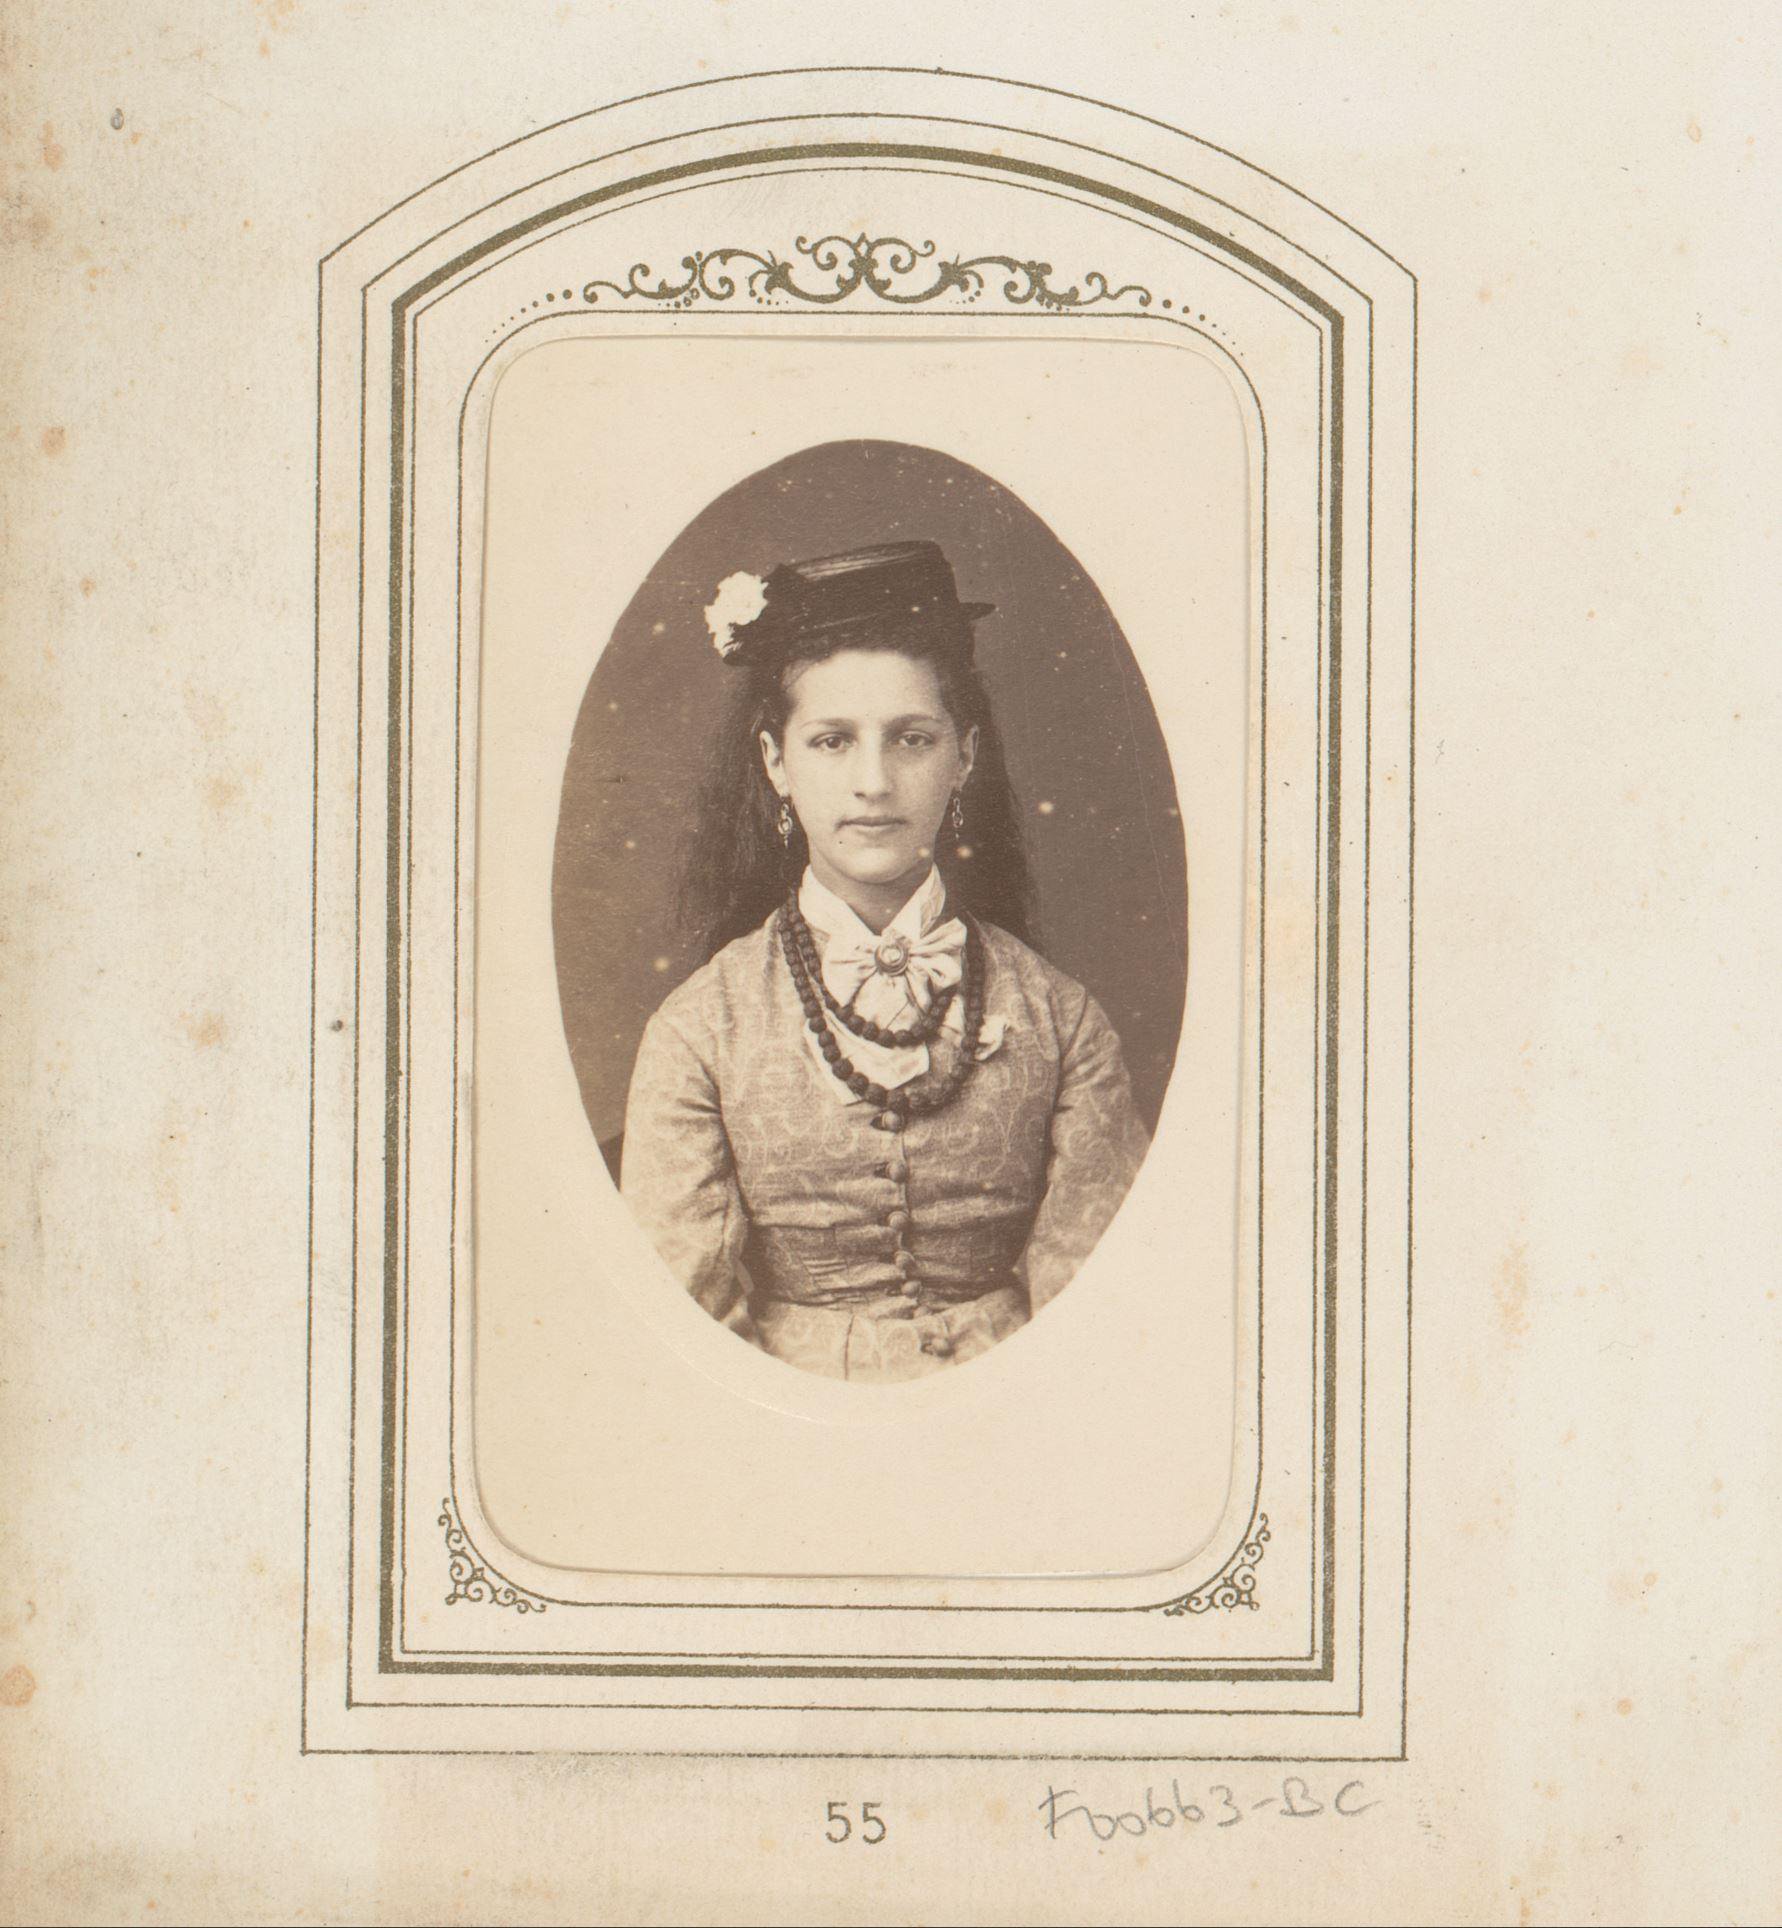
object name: photograph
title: Portret van een jonge vrouw met hoed, strik en ketting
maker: roelof loots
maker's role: fotograaf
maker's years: 1814-1898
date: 1860-1880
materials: cardboard, photographic support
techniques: albumen print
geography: medemblik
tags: historical persons - bb - woman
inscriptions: inscription: ‘Atelier Photographique/ R. Loots/ Nieuwstraat/ Medemblik’, number: ‘55’